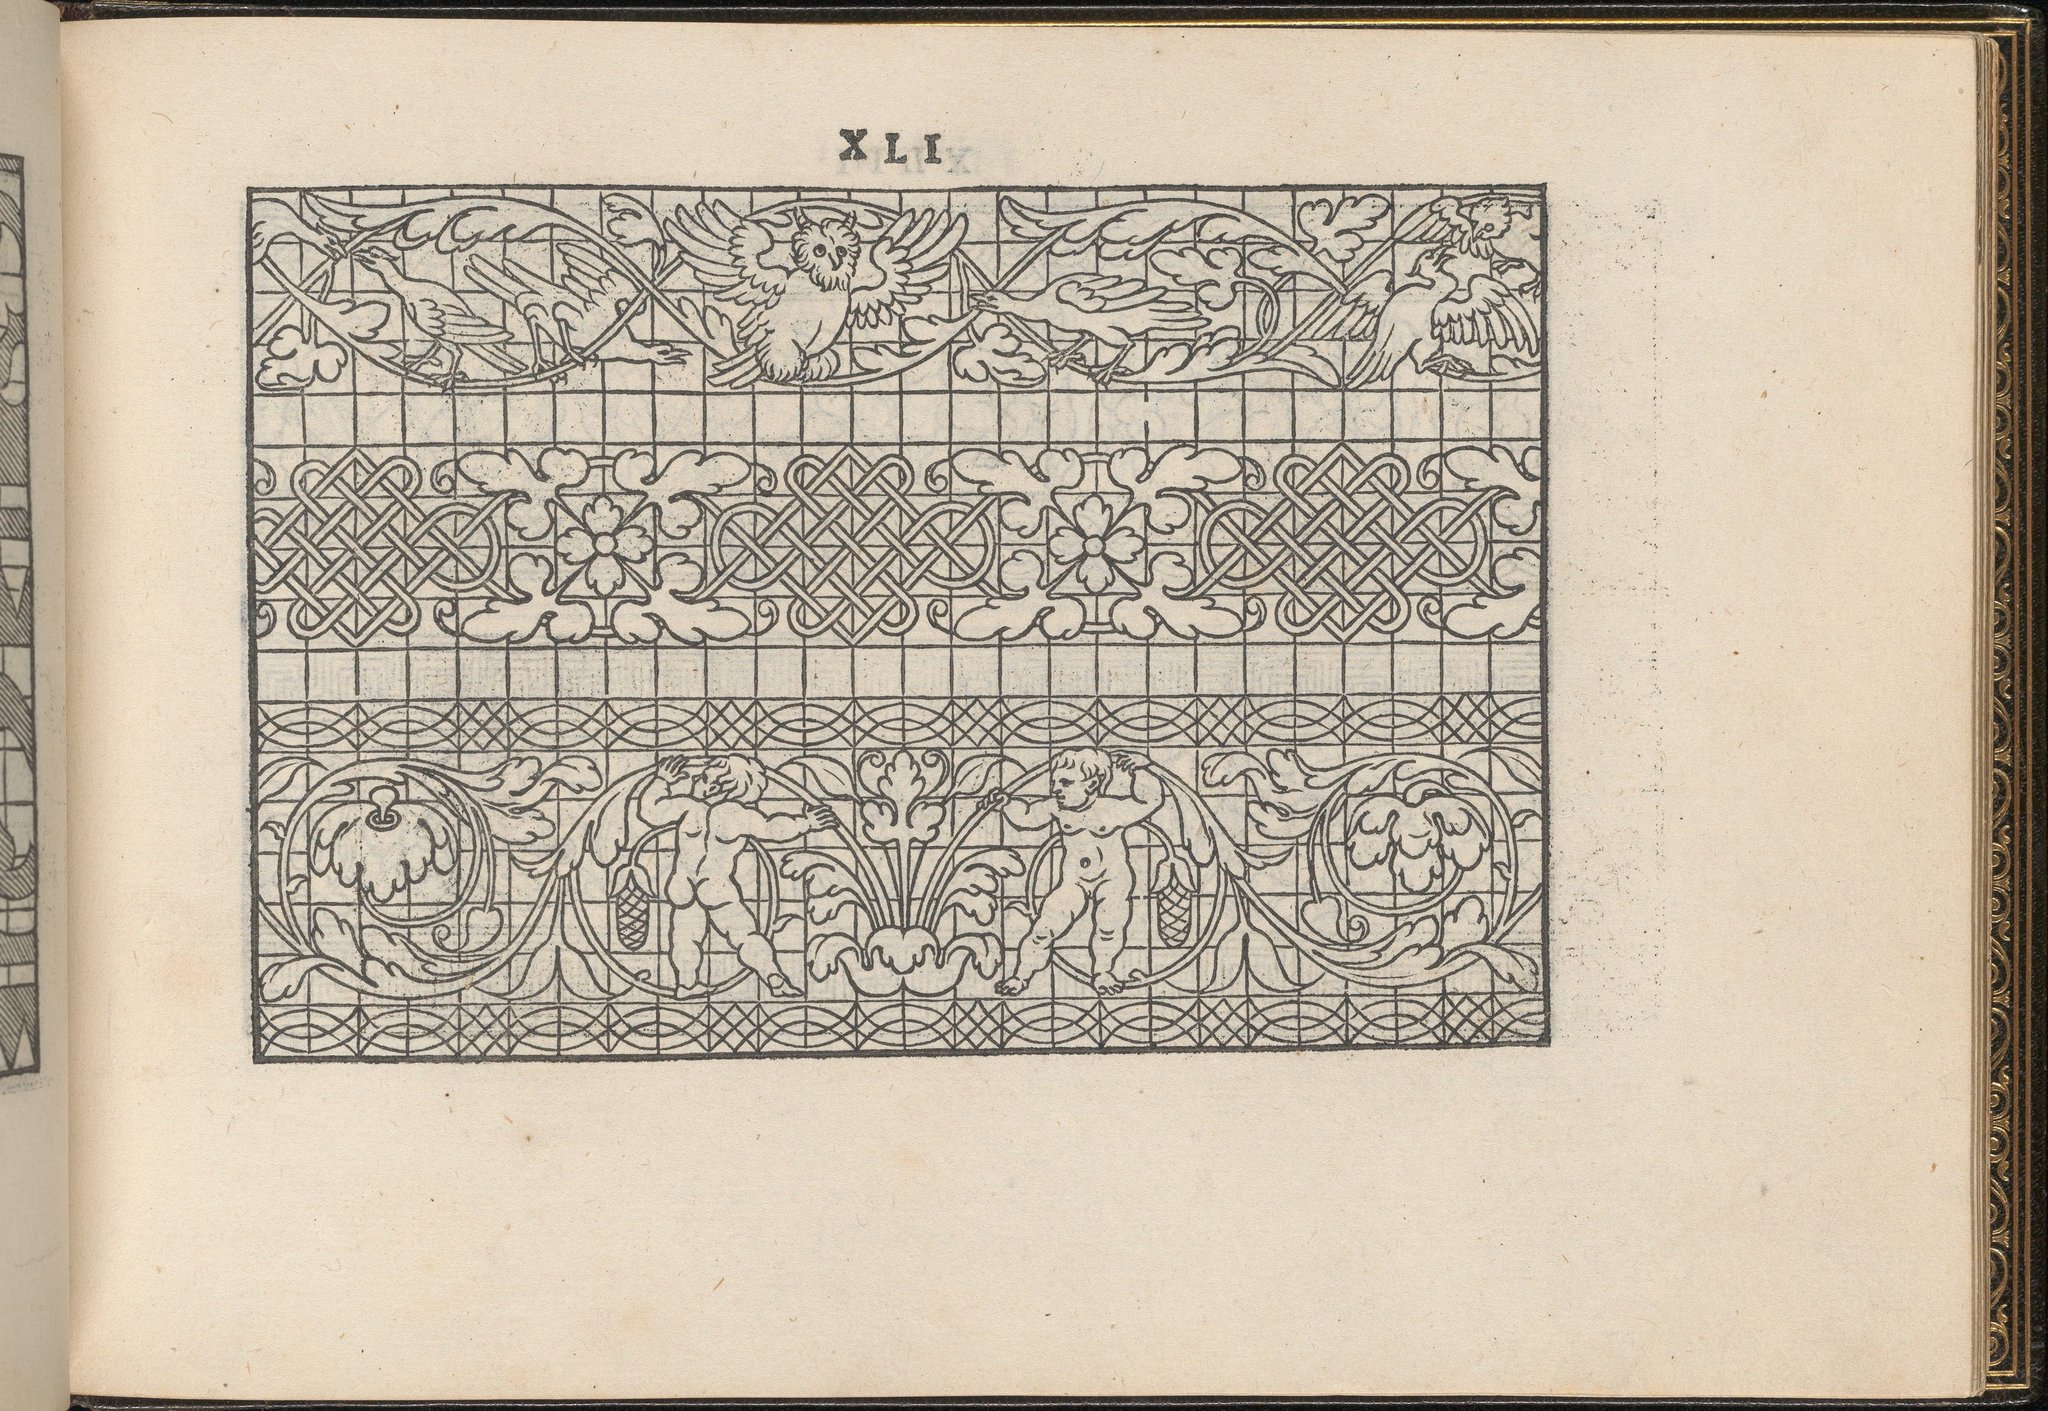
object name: book print ornament architecture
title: La Vera Perfettione del Disegno di varie sorti di recami, page 21 (recto)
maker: giovanni ostaus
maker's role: publisher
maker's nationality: italian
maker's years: 1507-1607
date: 1567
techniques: woodcut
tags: birds,owls